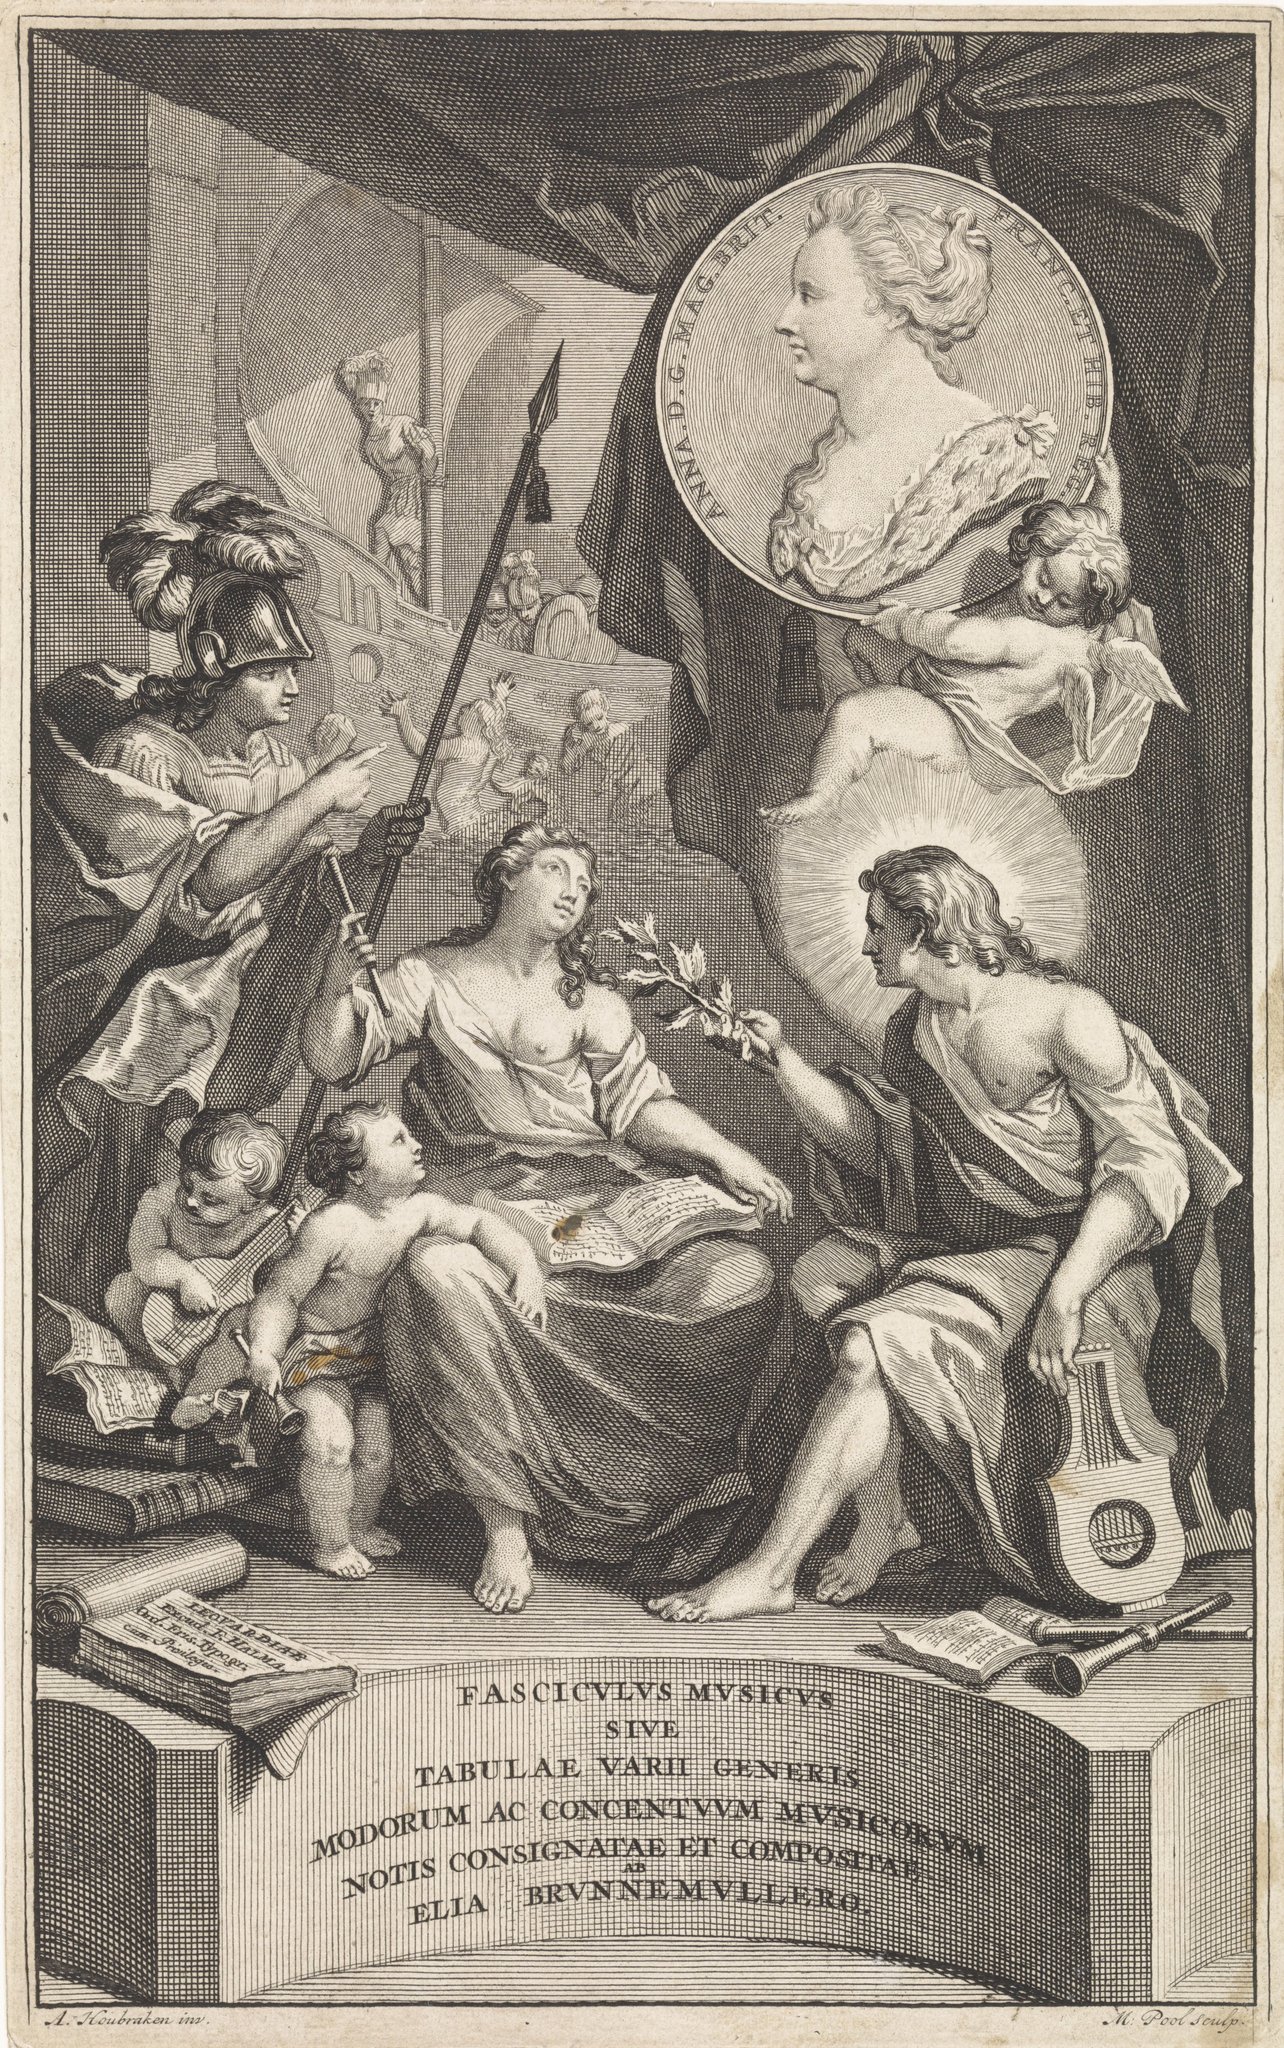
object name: titelblad, titelpagina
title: Allegorische titelpagina met de personificatie van Muziek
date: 1710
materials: paper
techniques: engraving, etching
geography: amsterdam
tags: london, anna stuart (koningin van engeland en schotland), notation of music, minerva as patroness, 'musica', symbolic representations, allegories and emblems ~ music; 'musica'(ripa), specific aspects, allegorical aspects of apollo; apollo as patron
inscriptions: collector's mark: Lugt 2228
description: Op een verhoging zit de personificatie van Muziek, met een liedboek op haar schoot. Apollo overhandigt haar een olijftak. Achter haar staat Minerva die wijst op het portret van Anna Stuart, koningin van Engeland. Op de achtergrond een schip met een vastgebonden soldaat. Een zeemeermin slaat wanhopig haar armen naar hem op.